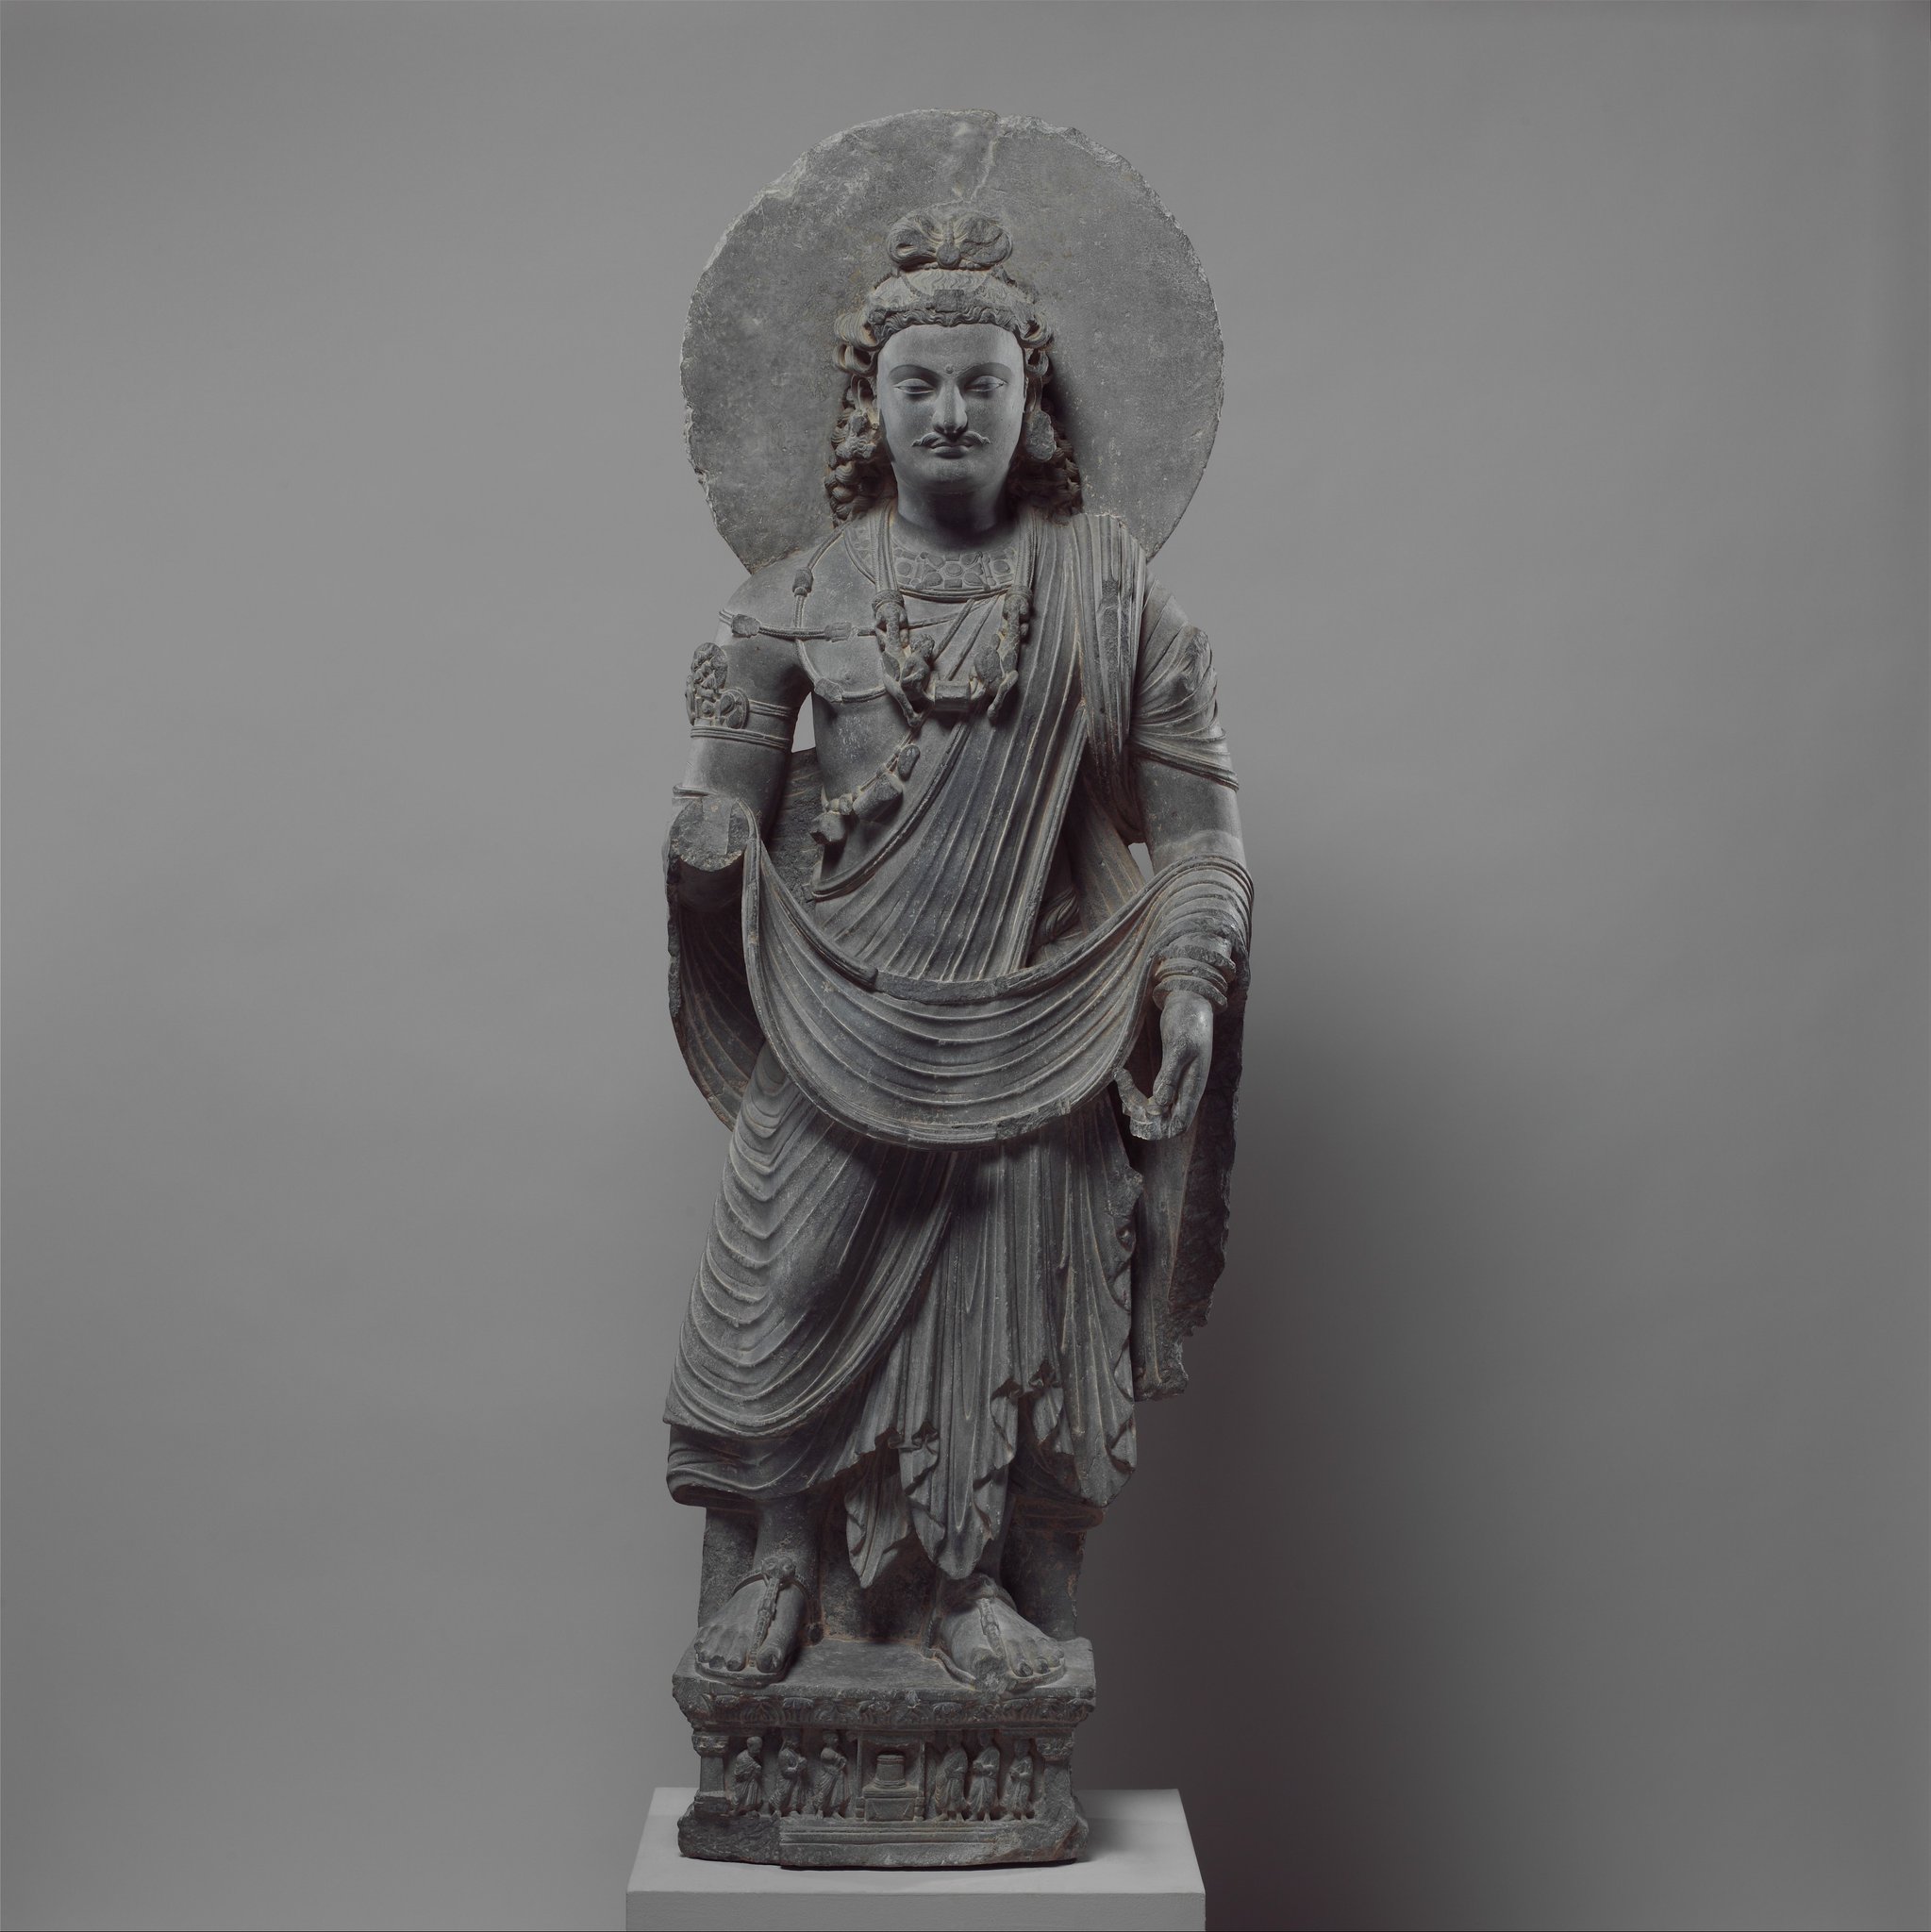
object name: statue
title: Standing Bodhisattva Maitreya (Buddha of the Future)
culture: gandhara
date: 201-300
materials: stone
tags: gandhara,buddhism,bodhisattvas,maitreya